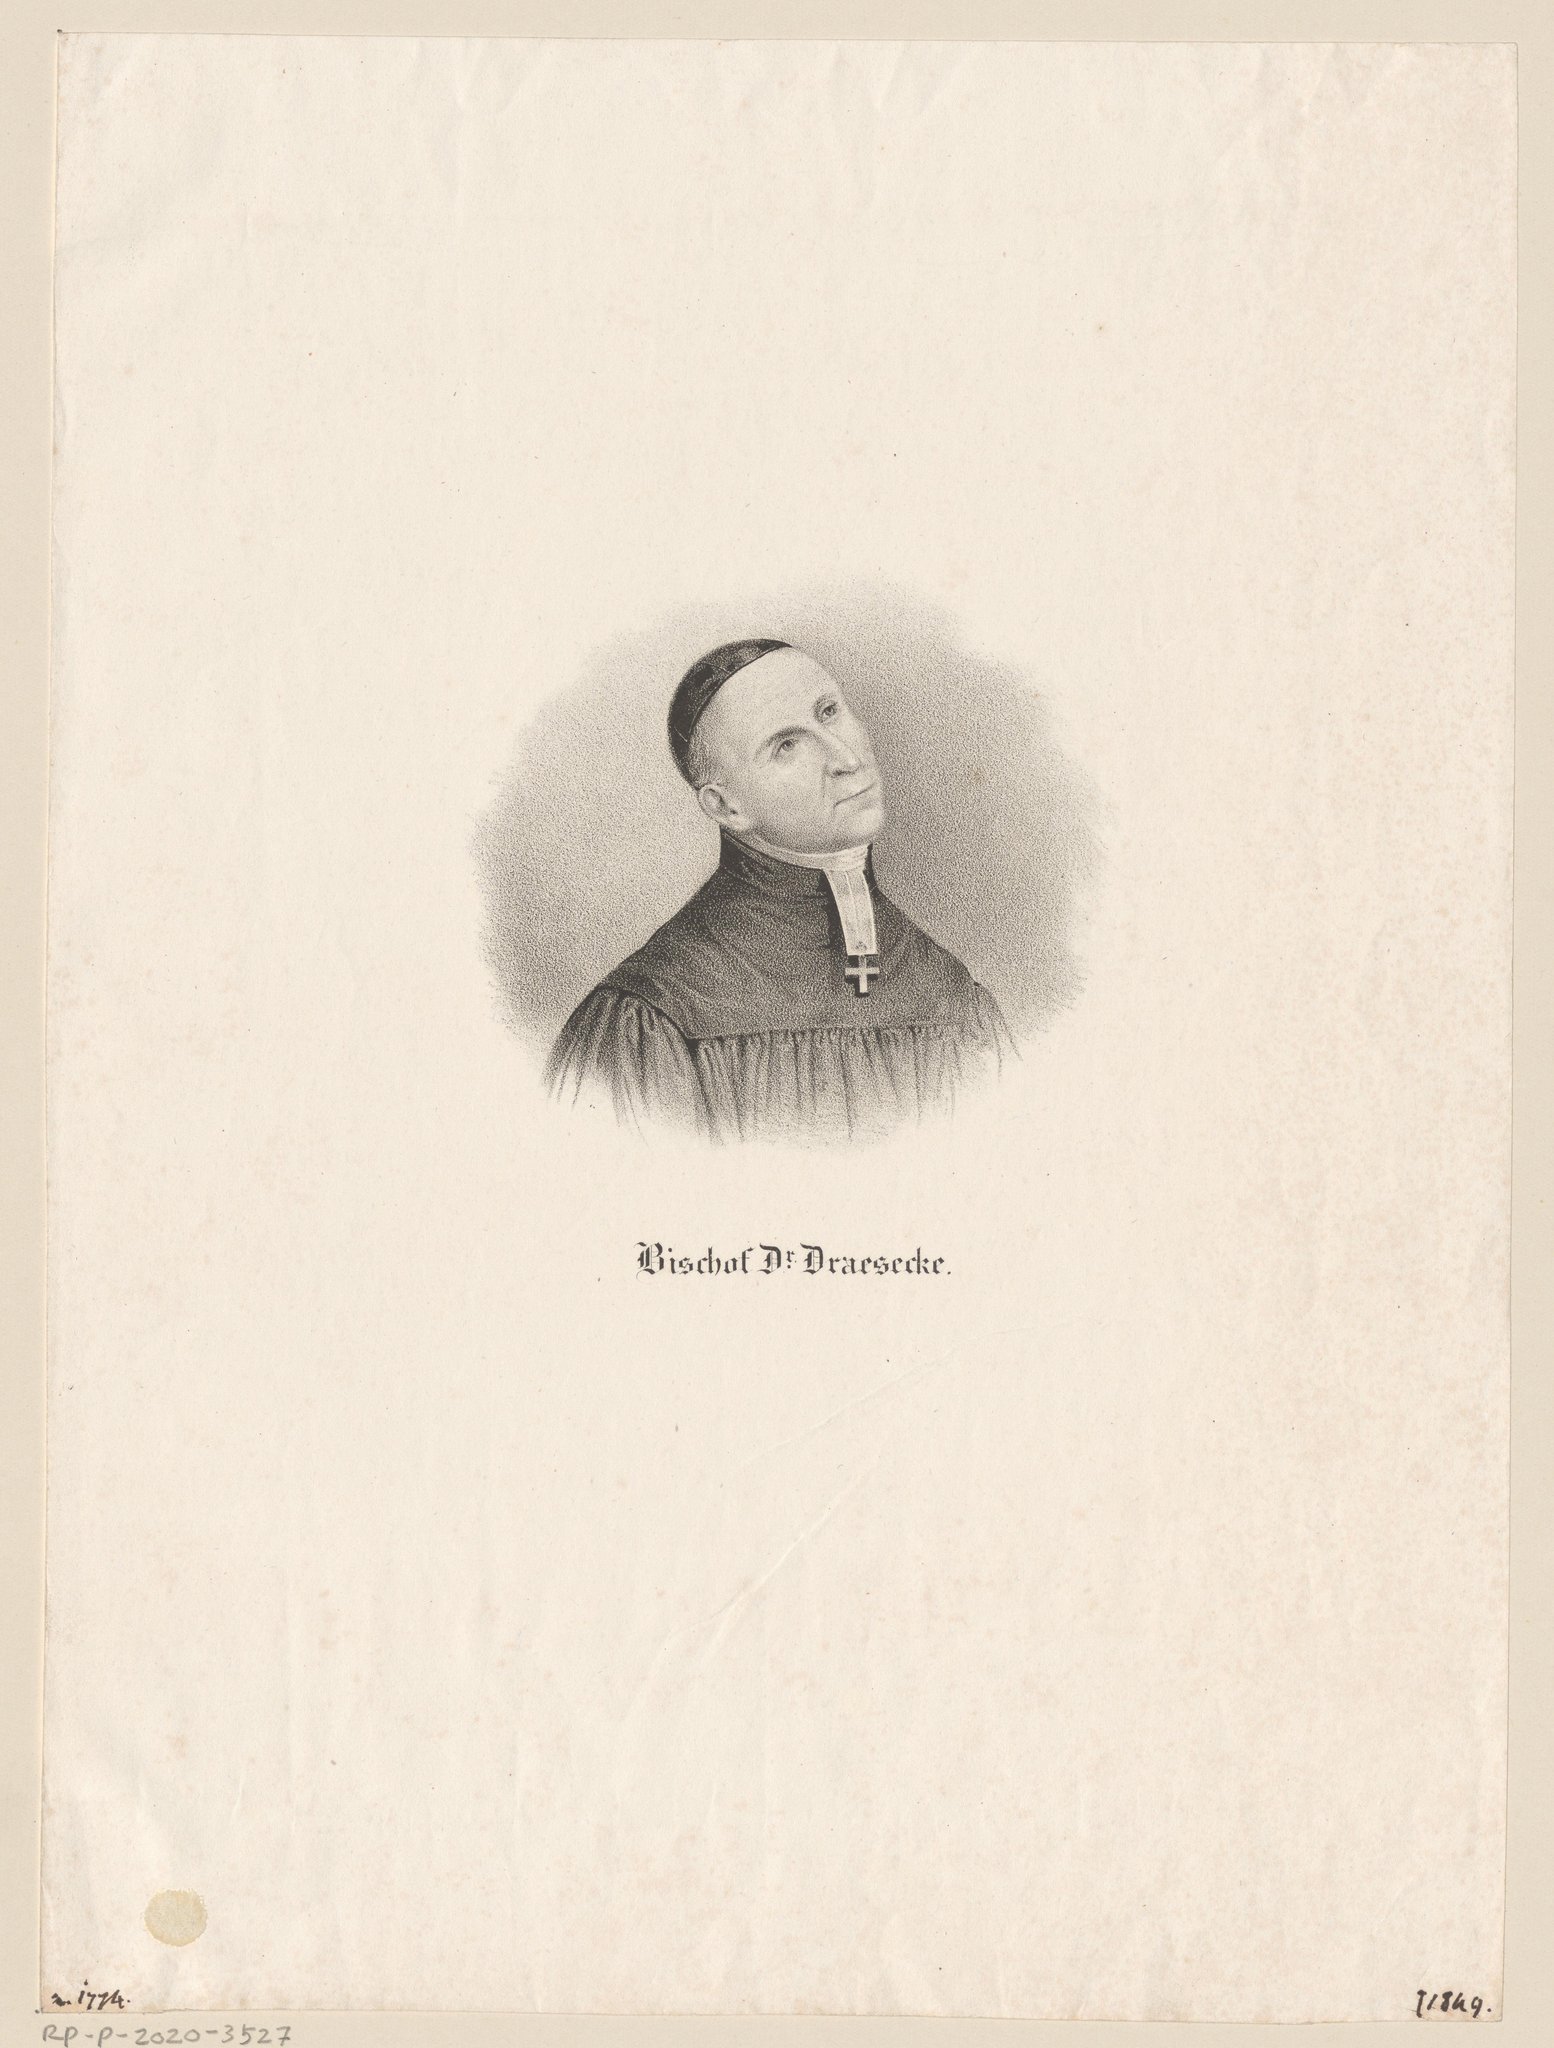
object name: print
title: Portret van Johann Heinrich Bernhard Dräseke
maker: Anonymous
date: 1800-1849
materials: paper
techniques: lithograph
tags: archbishop, bishop, etc. (roman catholic), theologian, historical persons